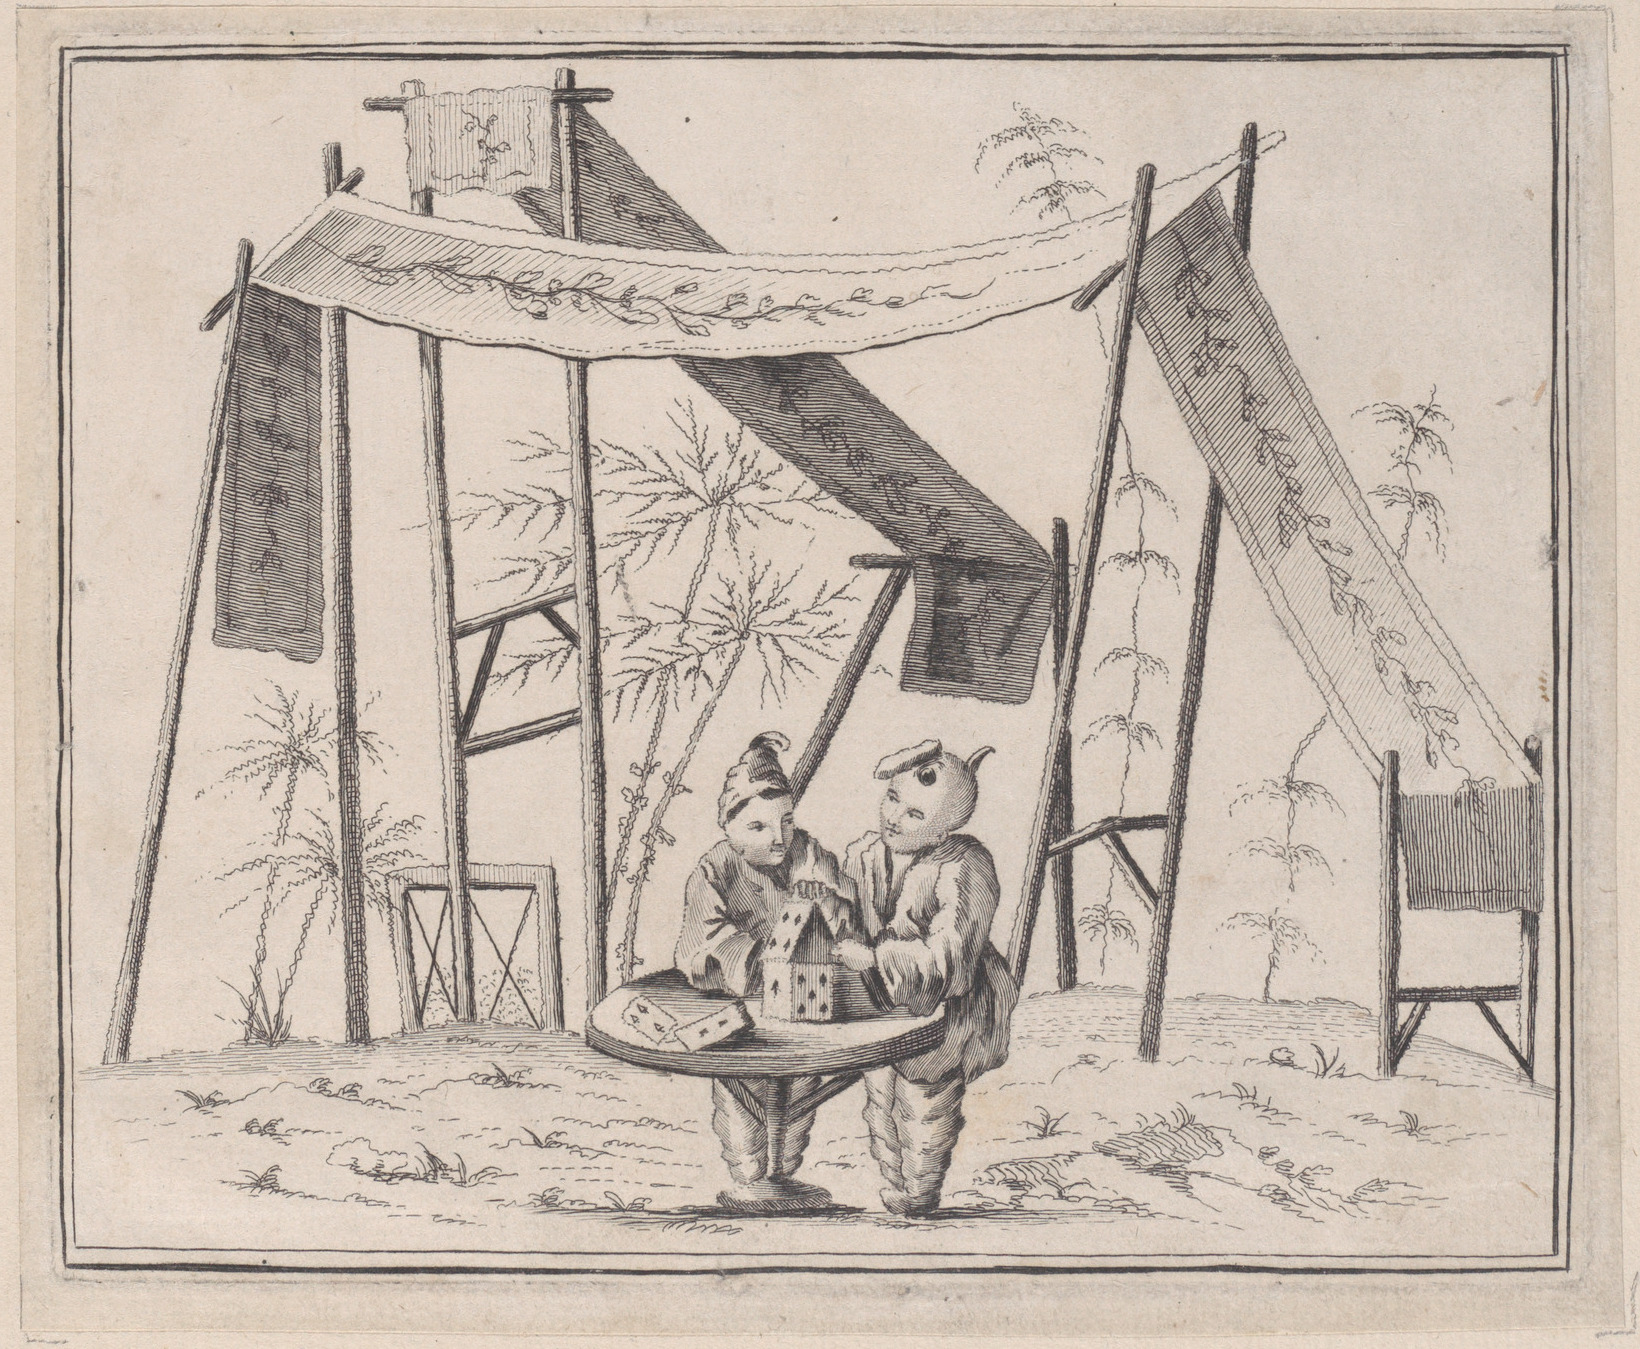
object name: print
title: Chinoiserie Ornament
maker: jean pillement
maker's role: artist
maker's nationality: french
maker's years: 1728-1808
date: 1760-1785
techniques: etching